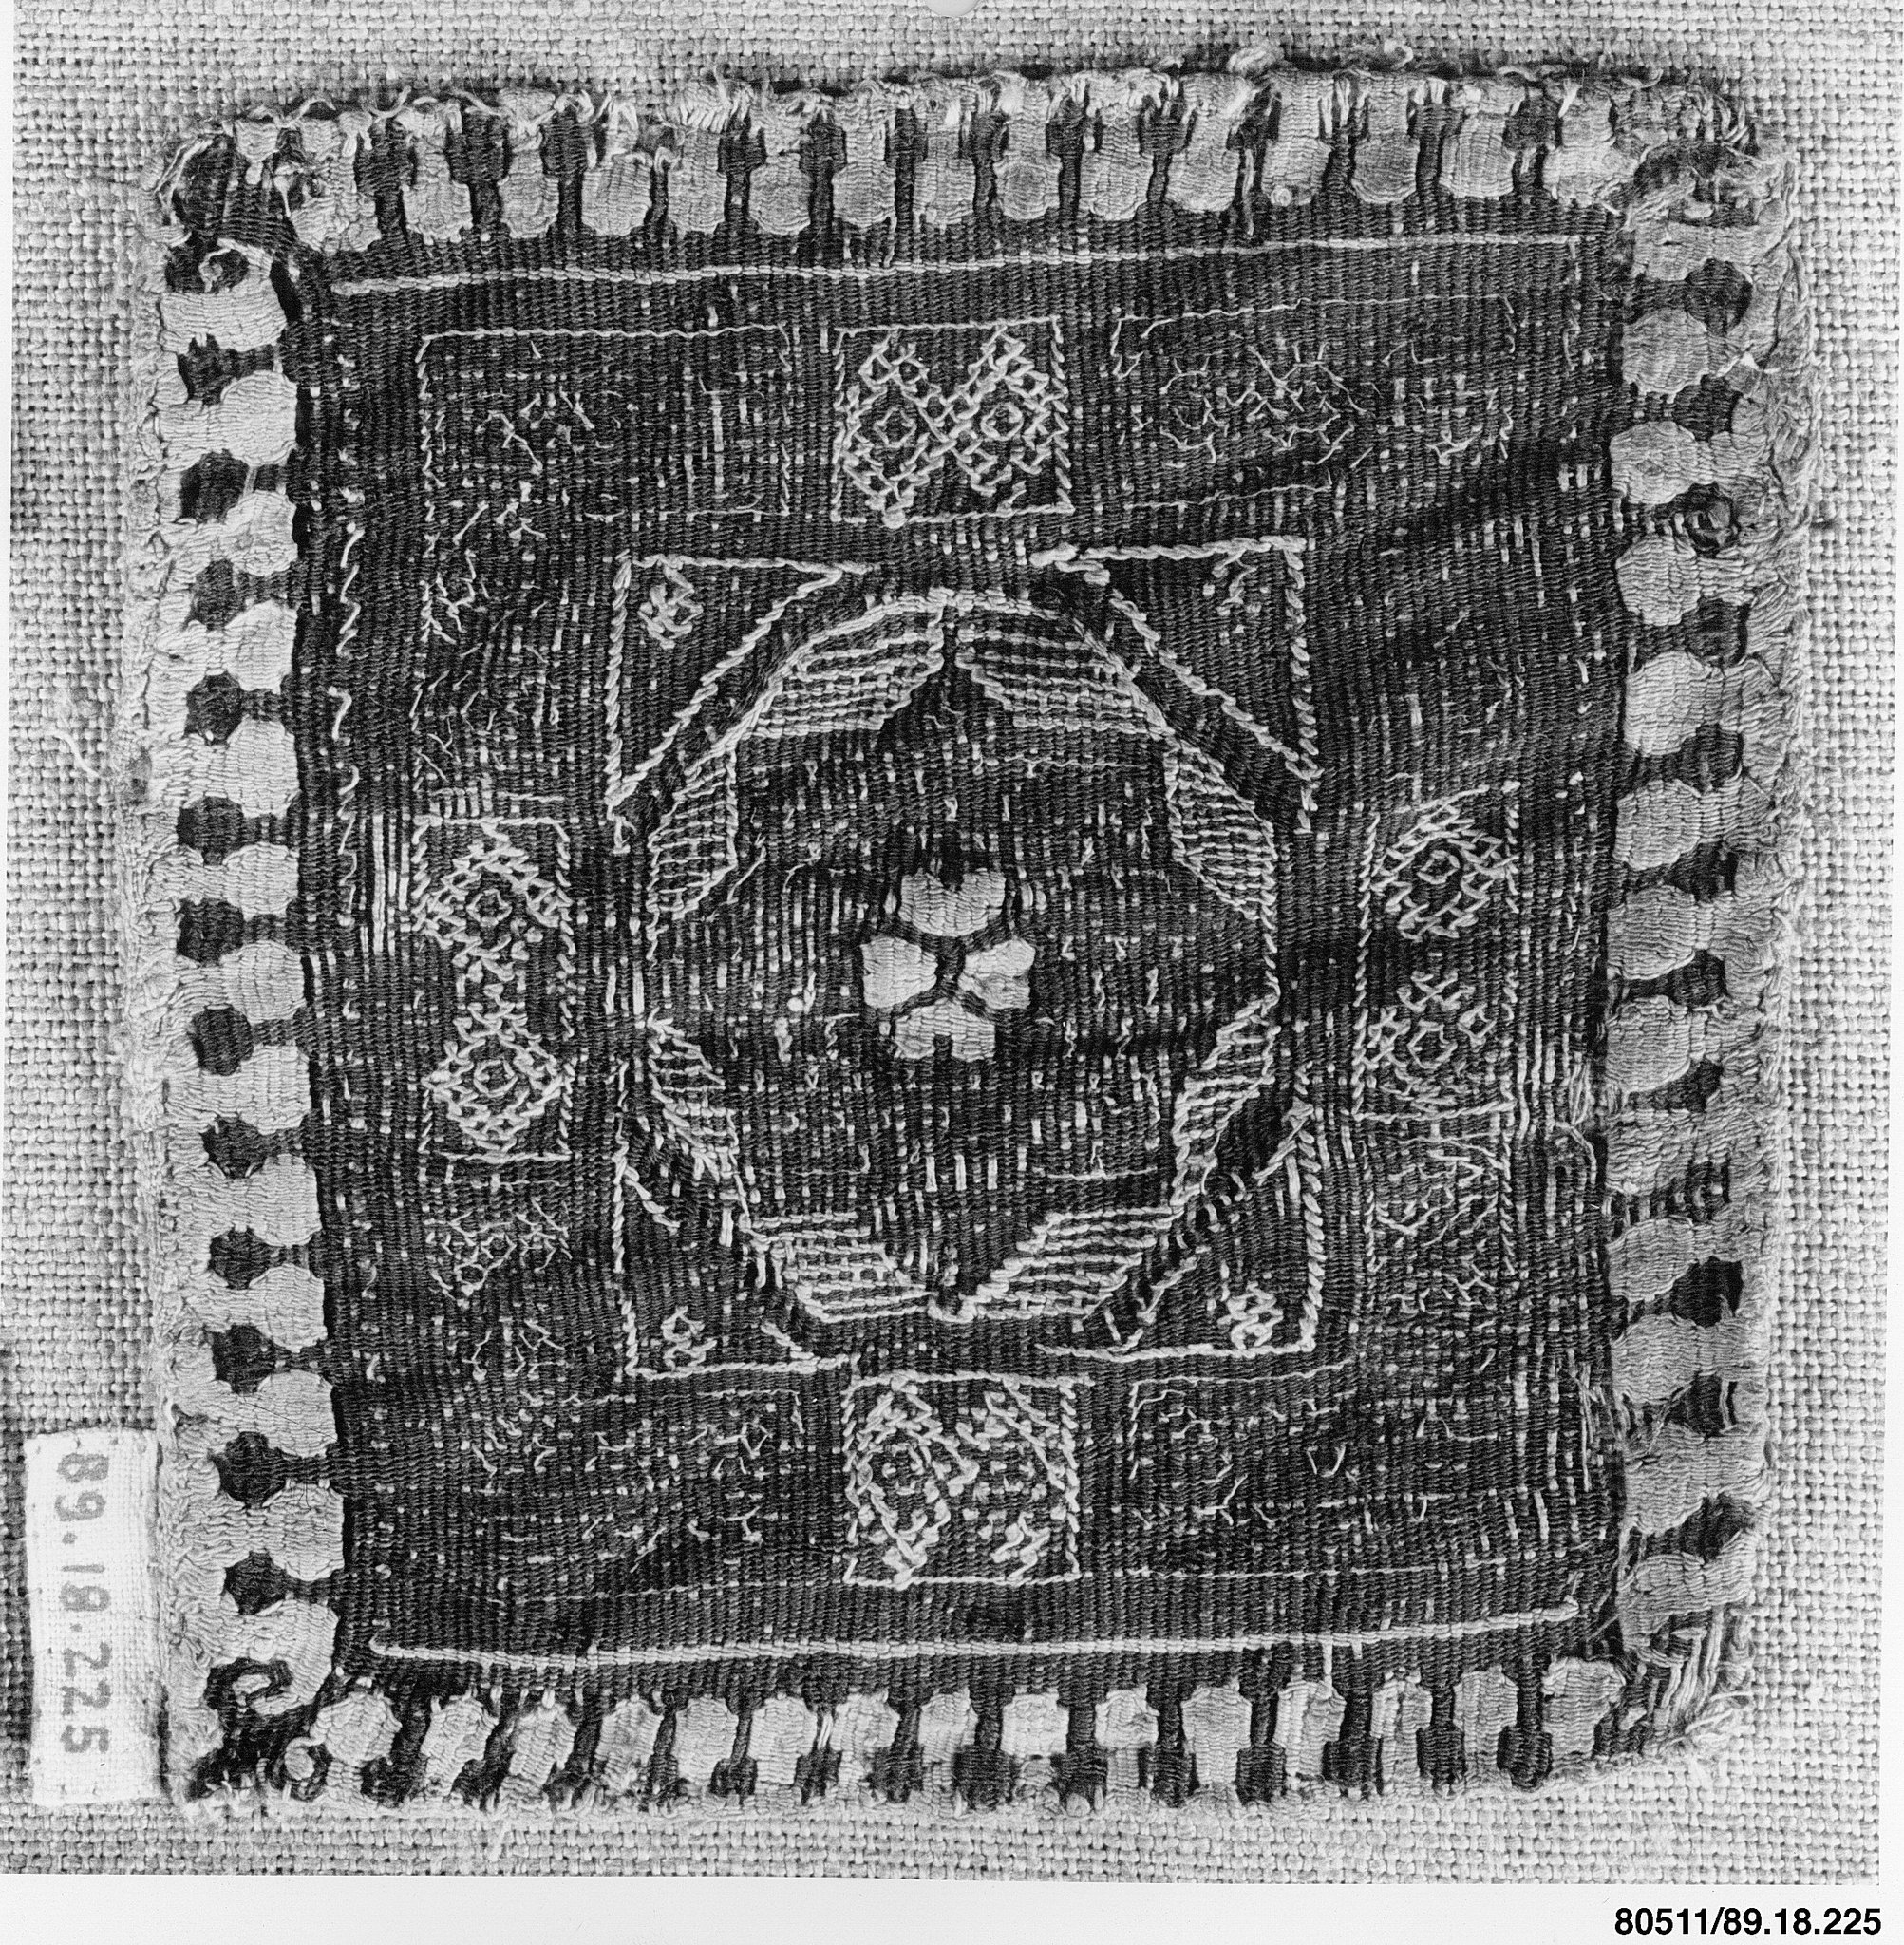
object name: textile fragment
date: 201-400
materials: linen, wool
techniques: weave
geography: egypt